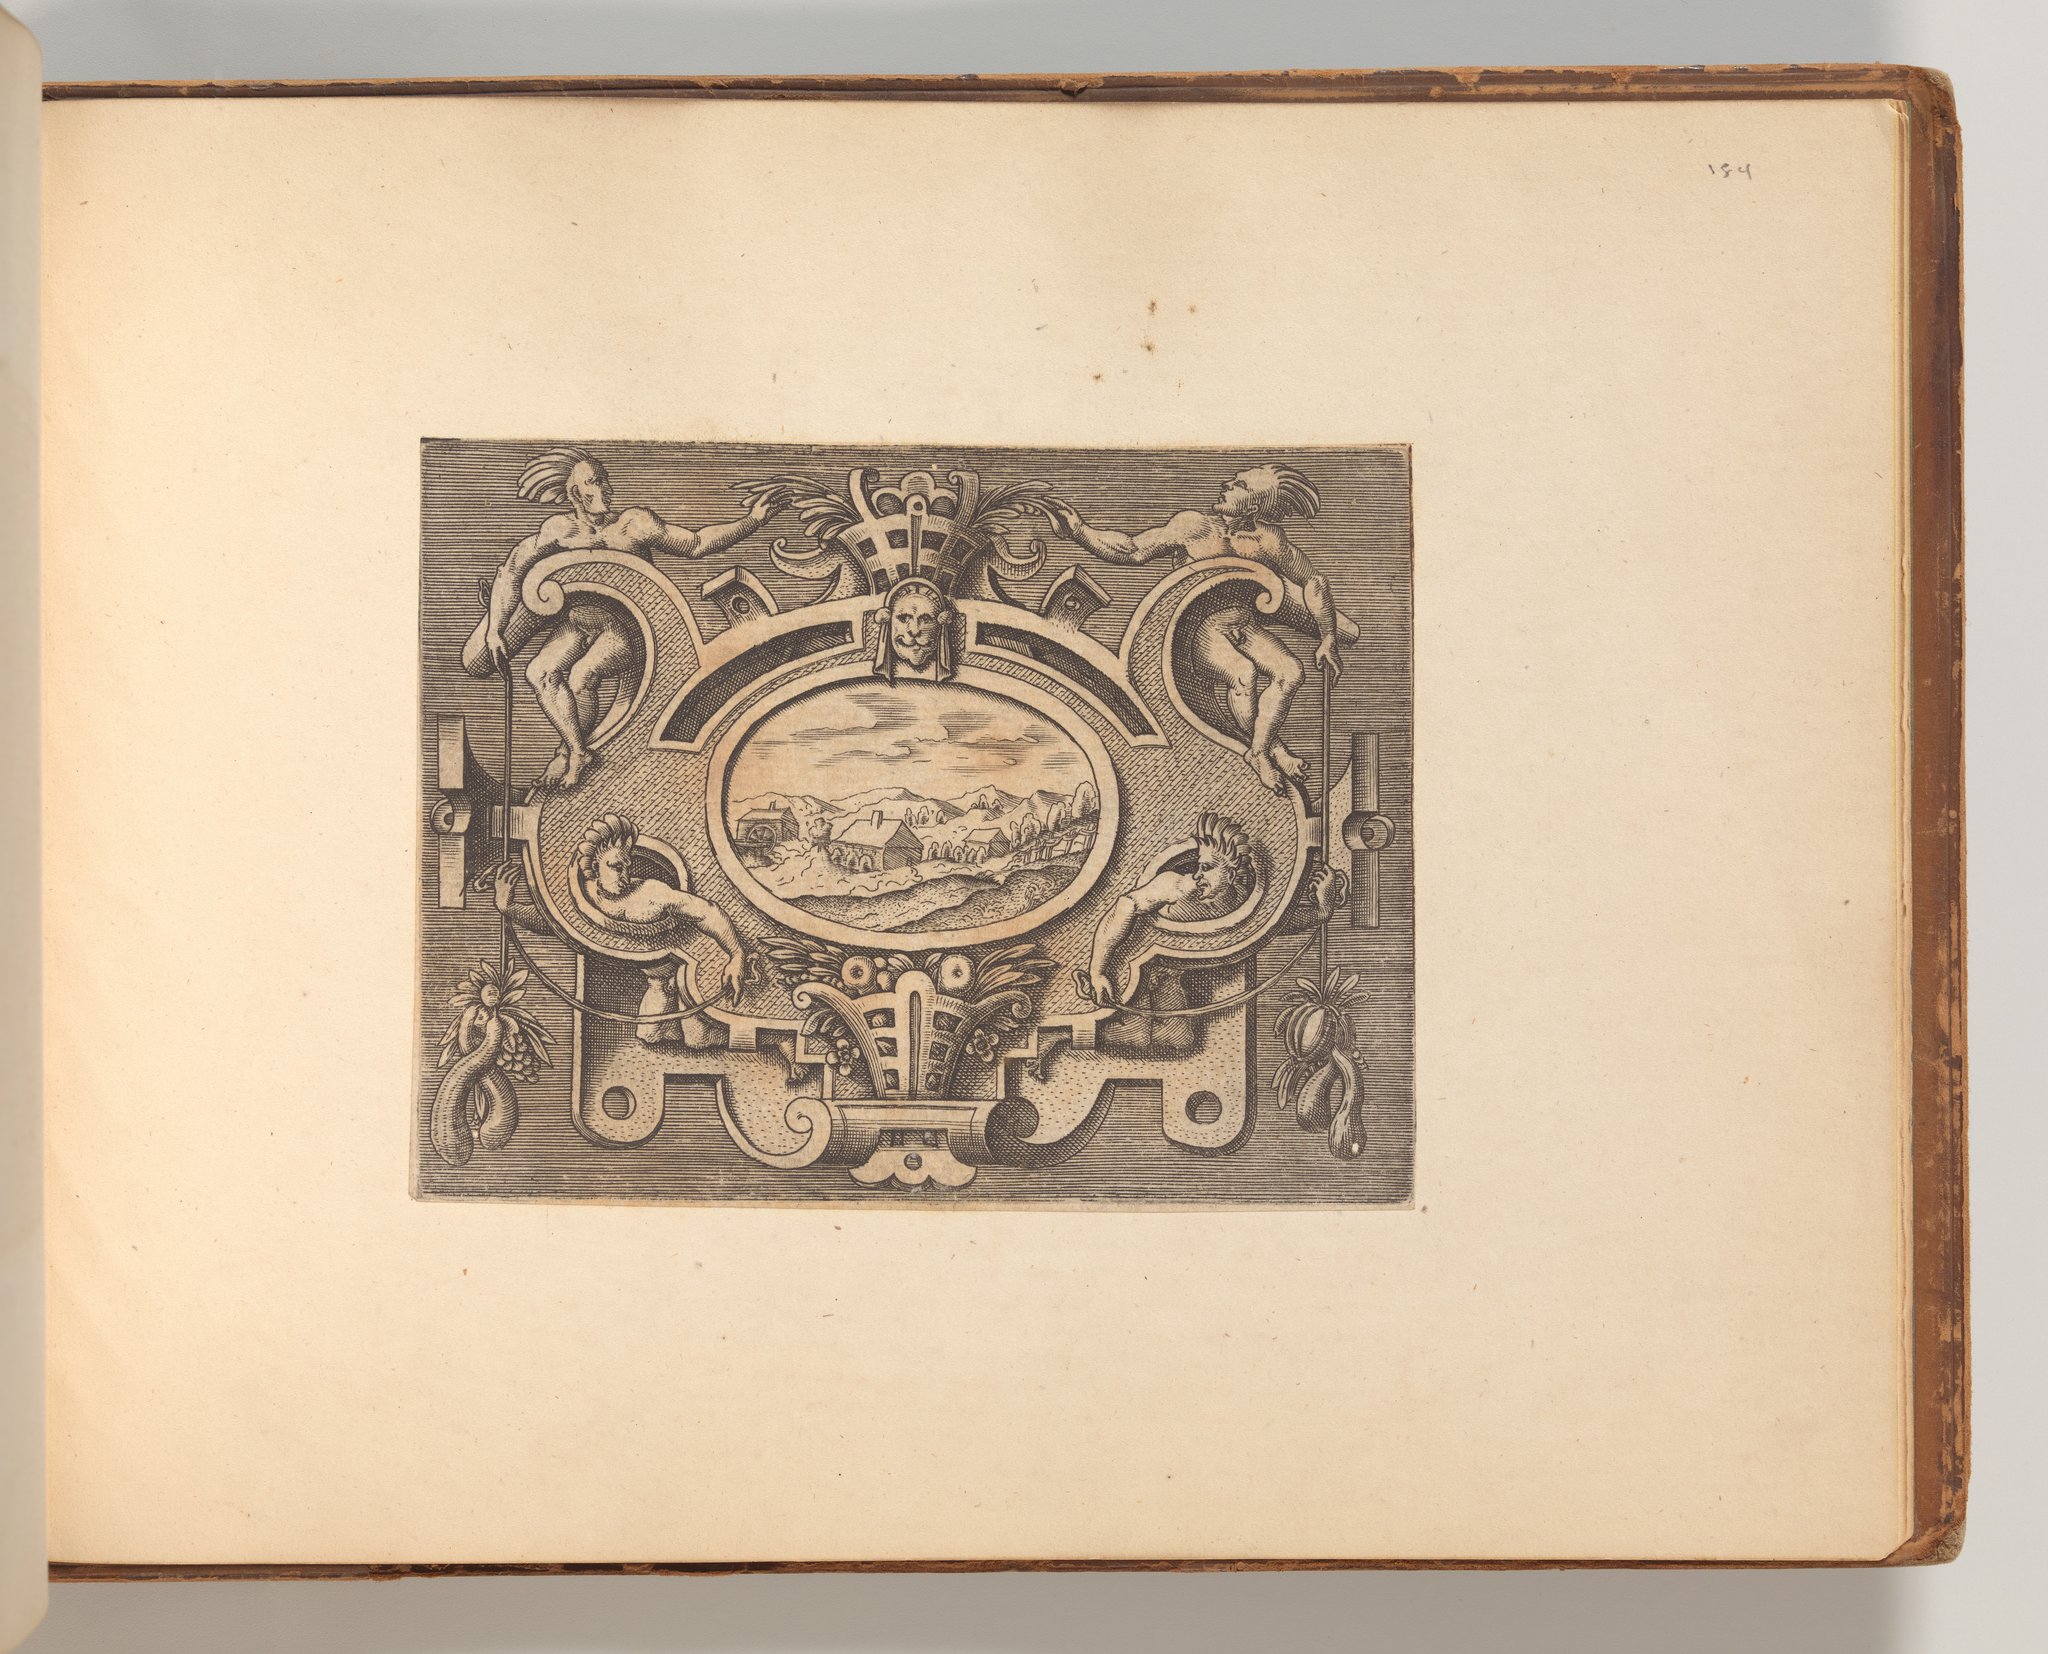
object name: album print ornament architecture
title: Series of Cartouches, in: Targhe ed altri ornati di varie e capricciose invenzioni (Cartouches and other ornaments of various and capricious invention, page 53)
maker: cornelis bos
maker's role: artist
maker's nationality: netherlandish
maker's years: 1510-1556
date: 1545-1560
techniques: engraving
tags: cartouches,men